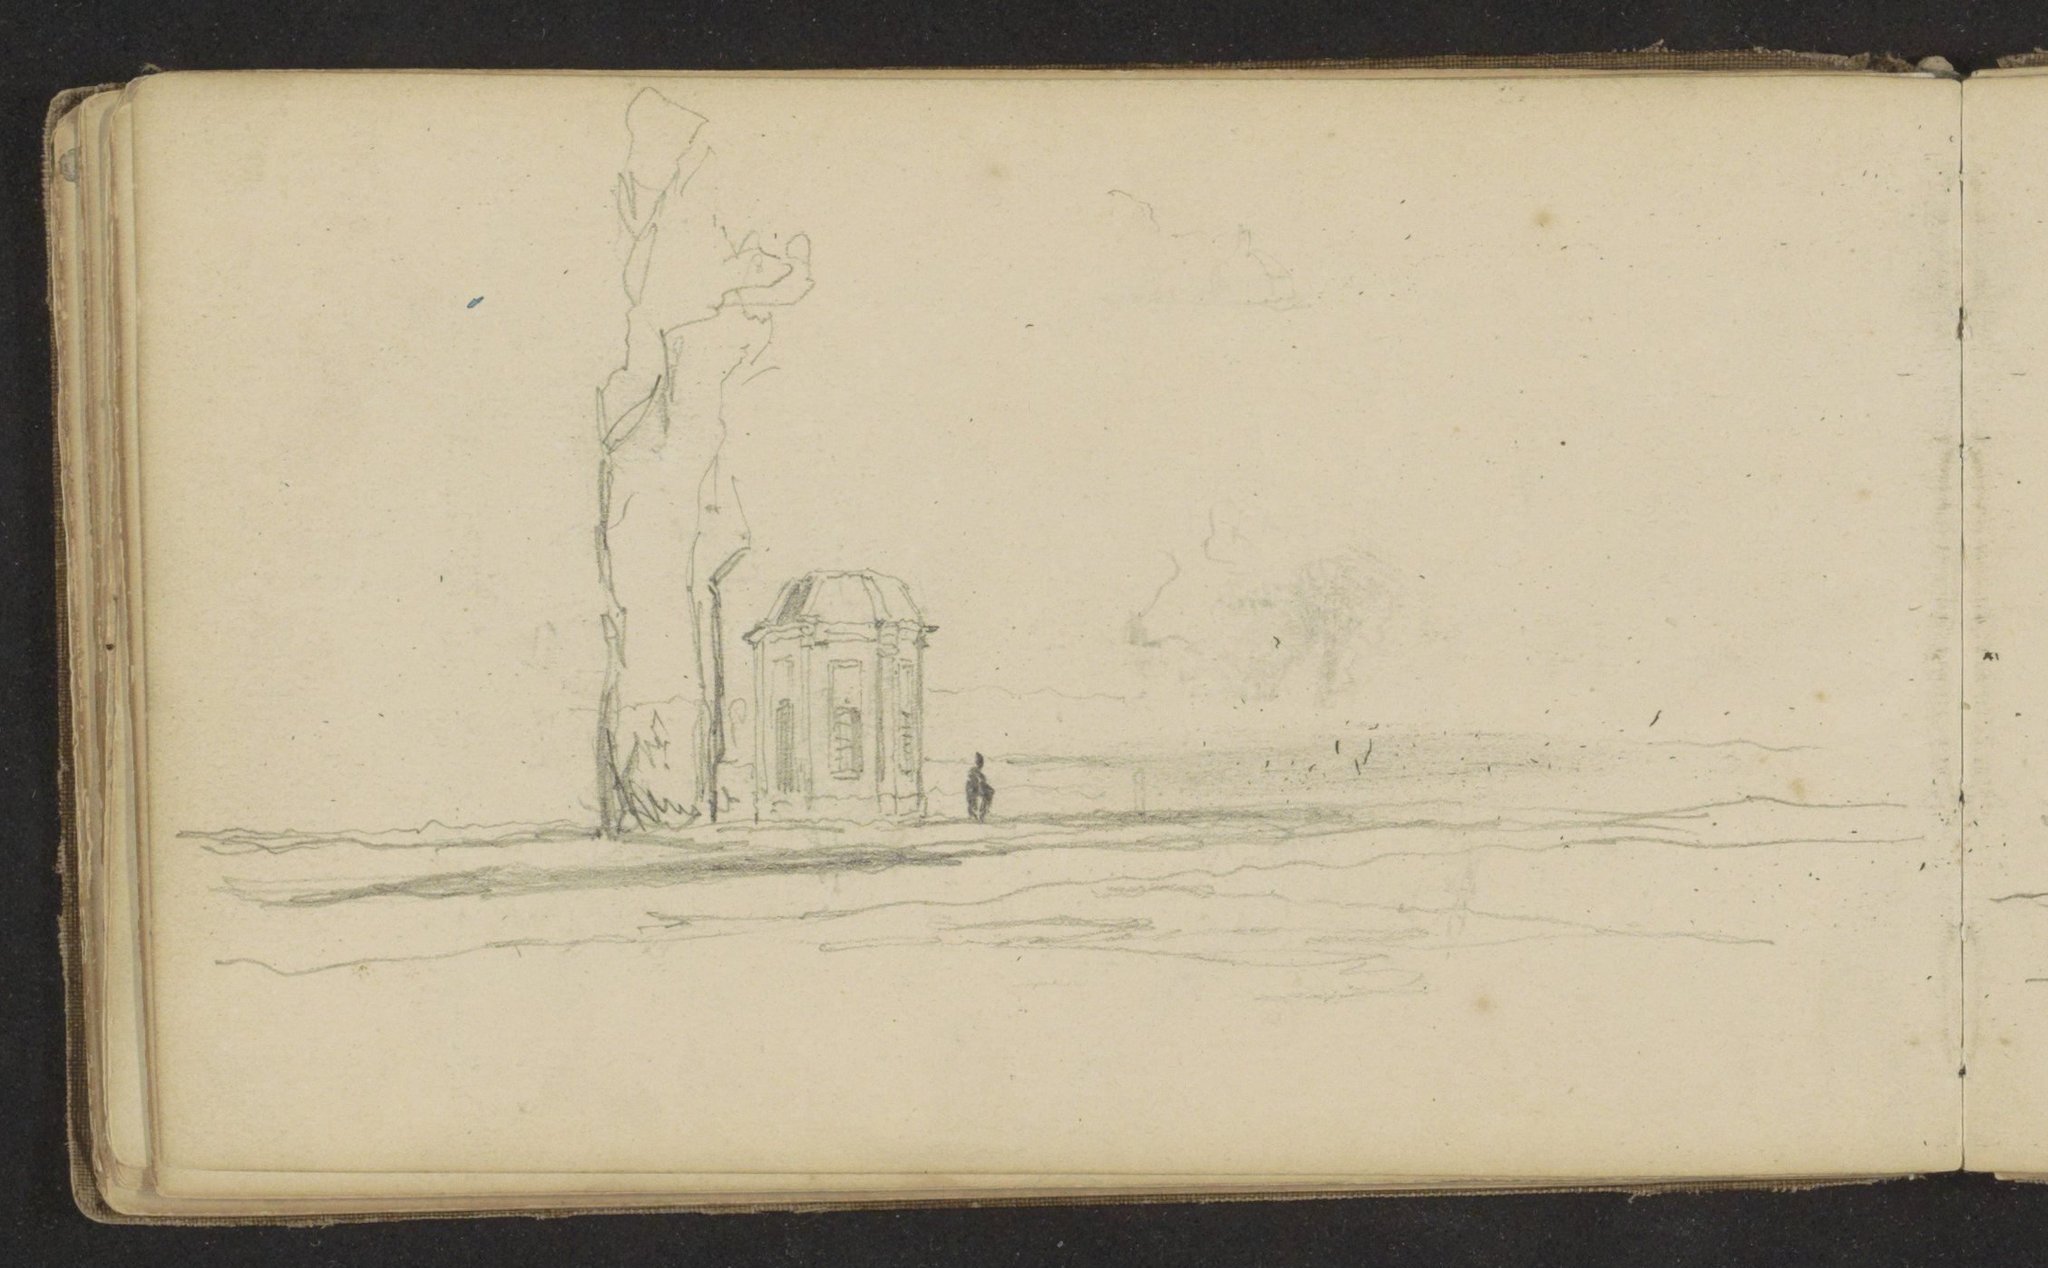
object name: sketchbook leaf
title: Theekoepel van Cromvliet aan de Vliet bij Rijswijk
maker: johan hendrik weissenbruch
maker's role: draughtsman, painter, print maker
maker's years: 1824-1903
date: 1834-1903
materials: paper, pencil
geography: rijswijk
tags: summer-house, arbour, garden-house (dutch: 'theekoepel')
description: Blad 25 verso uit een schetsboek met 43 bladen.